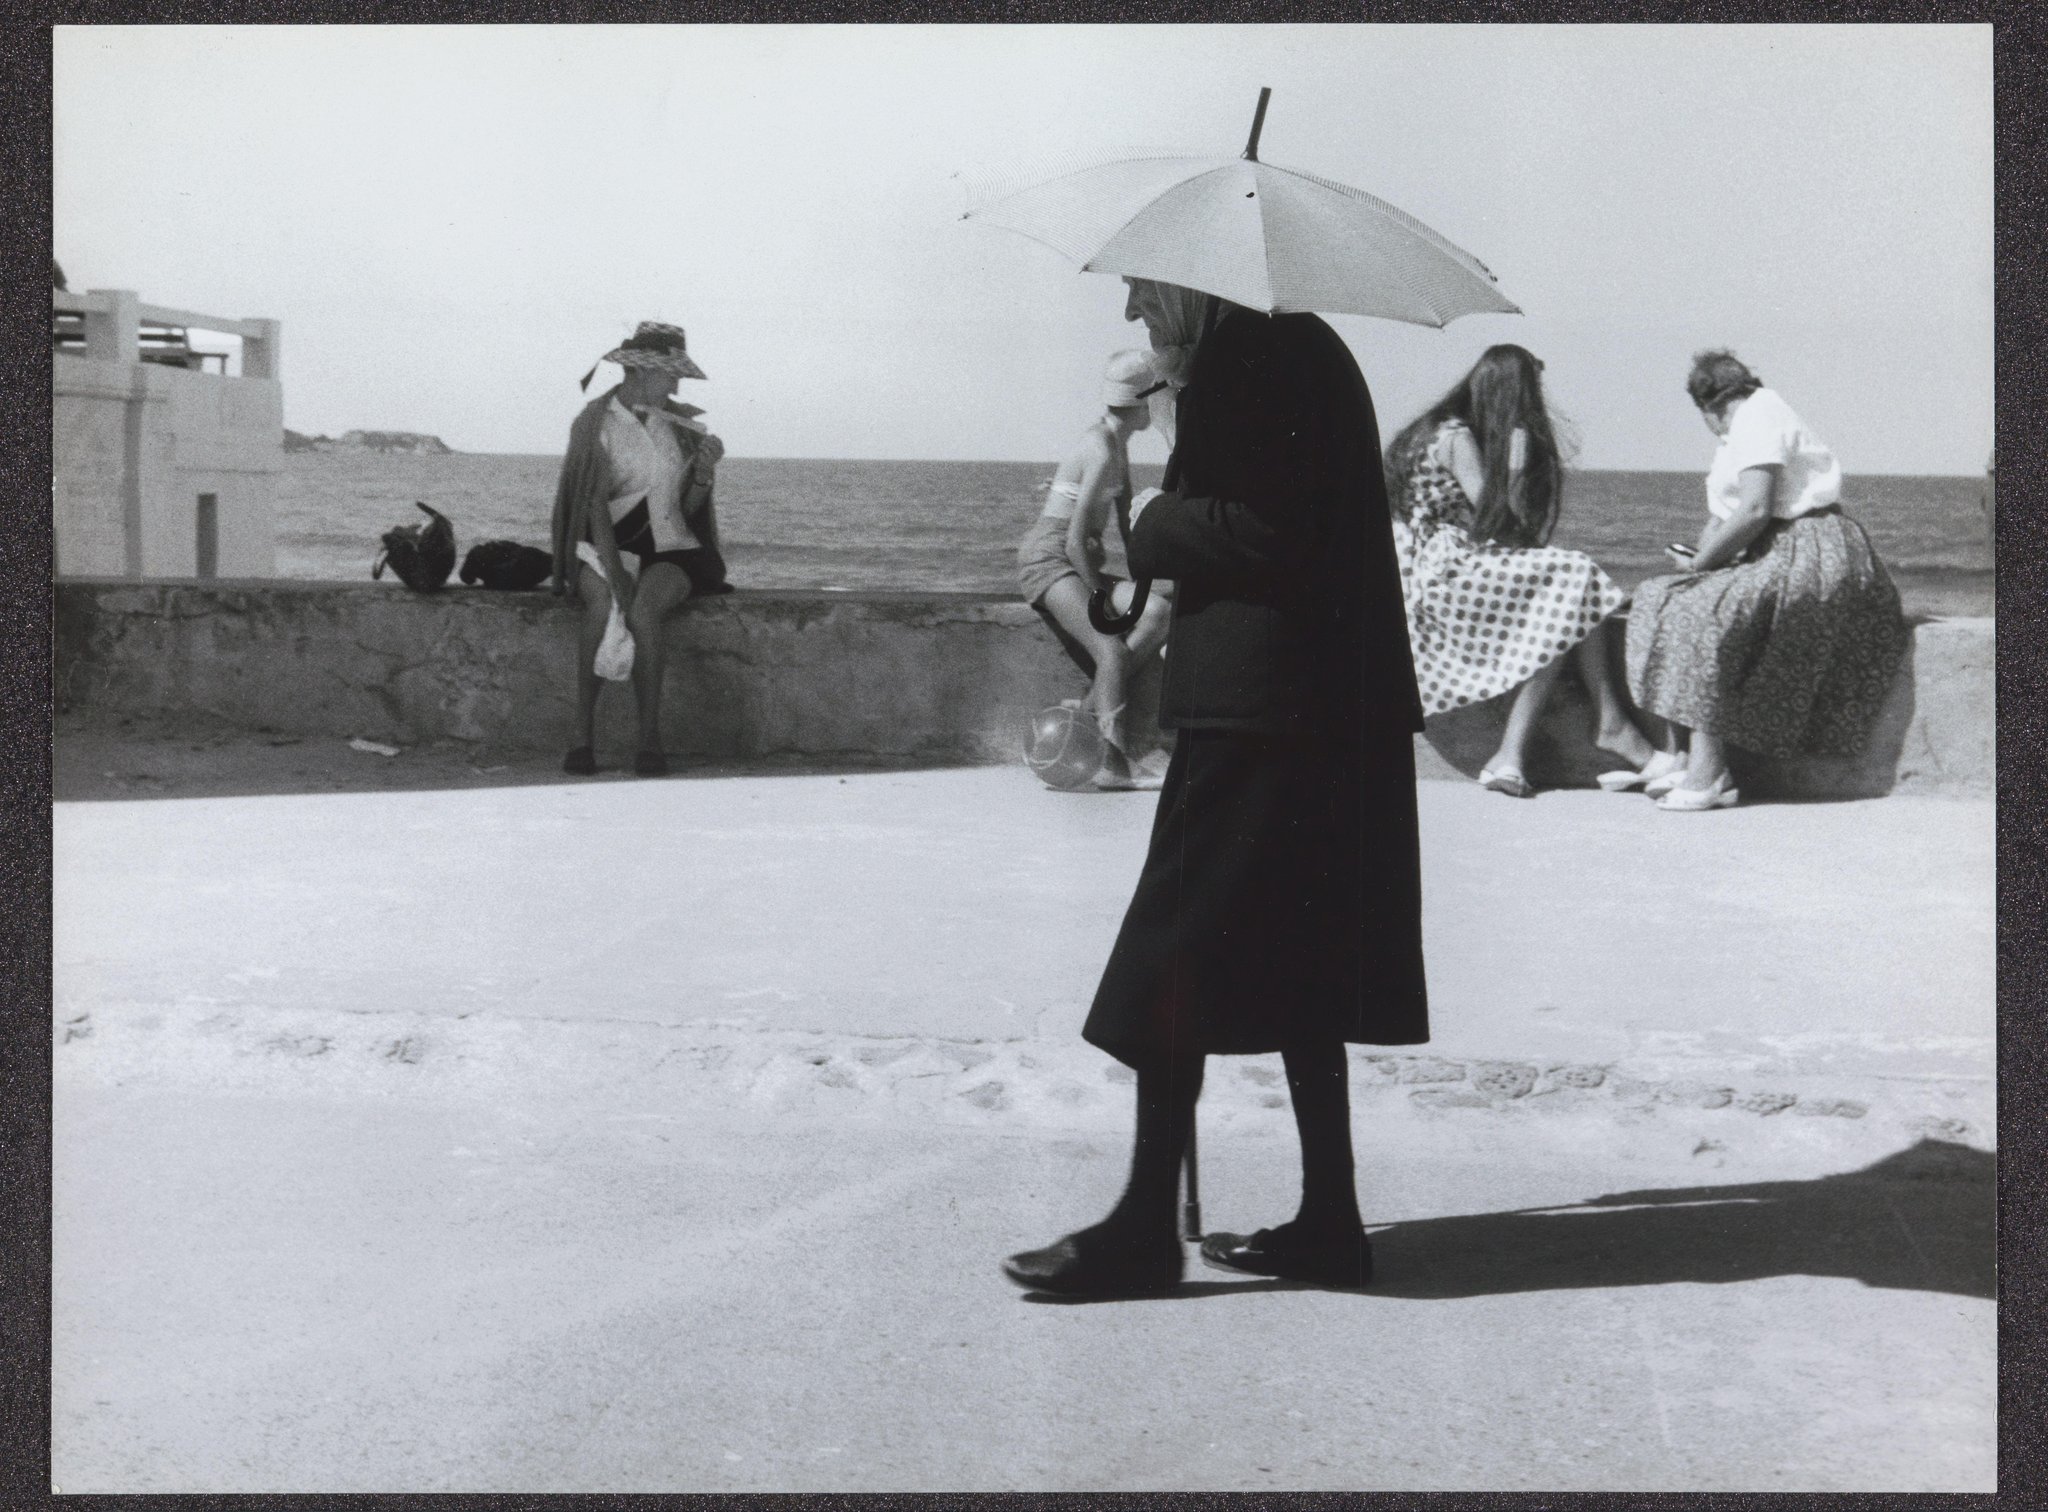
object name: photograph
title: Oude vrouw met parasol, lopend langs de kust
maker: Anonymous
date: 1955-1970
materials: paper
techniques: gelatin silver print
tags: old woman, walking, parasol, sunshade